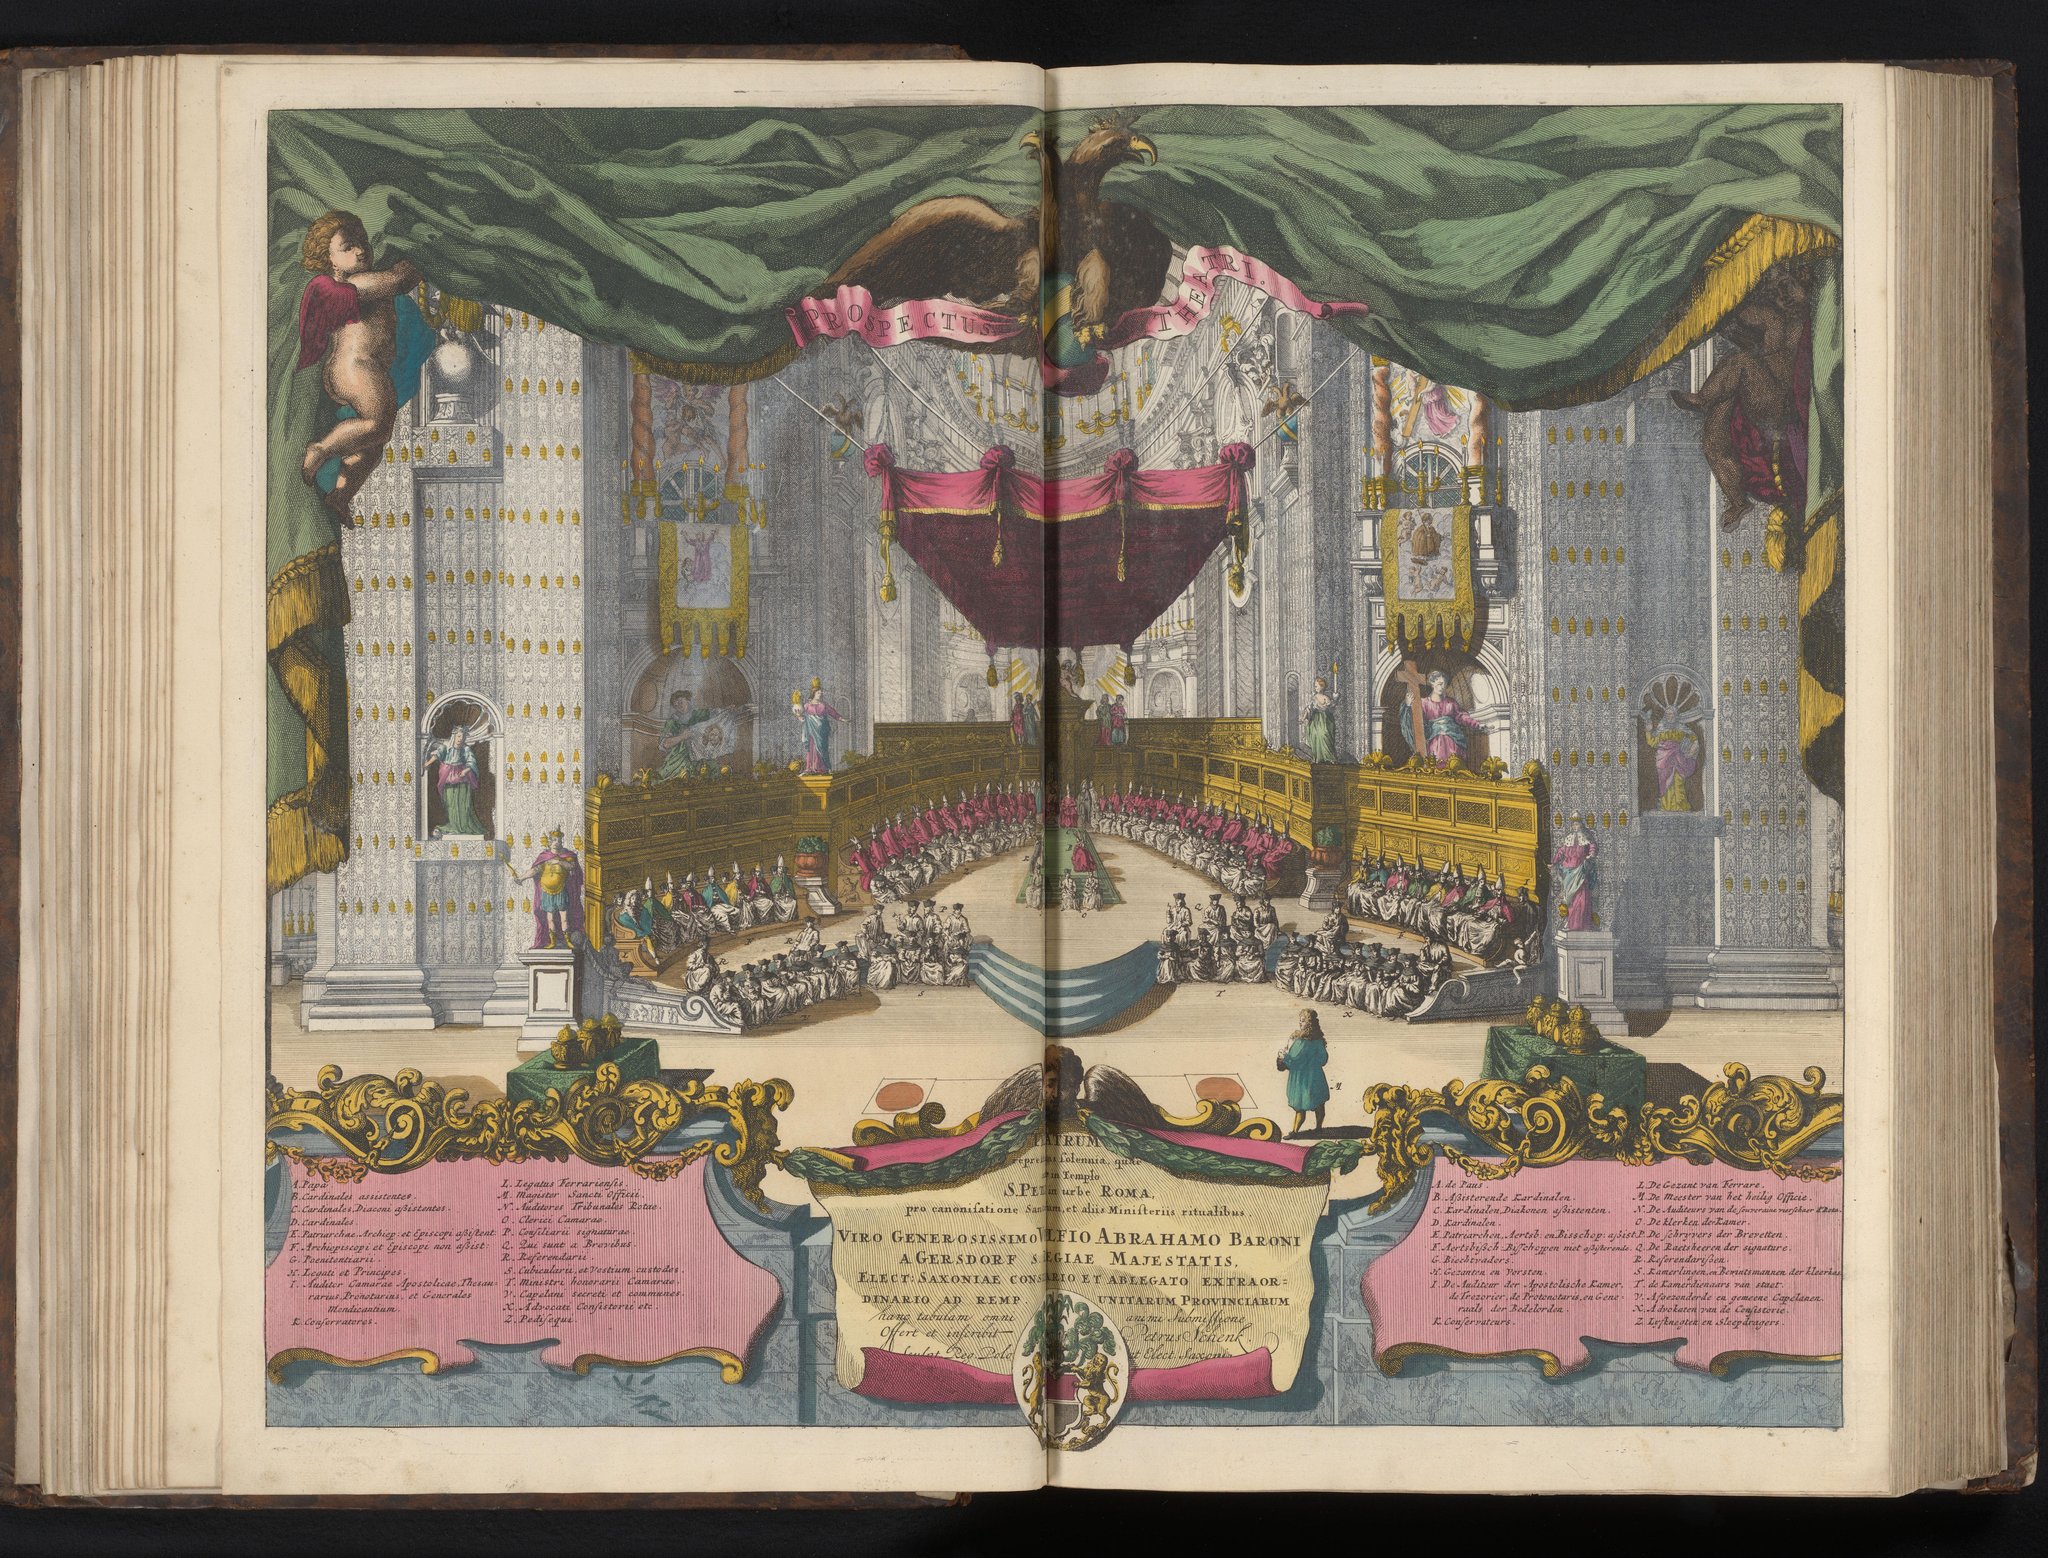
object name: album leaf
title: Gezicht in de Sint-Pietersbasiliek tijdens een heiligverklaring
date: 1675-1711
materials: paper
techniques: colour, etching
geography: the hague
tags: cardinal, interior of church, pope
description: Gezicht in het koor van de Sint-Pietersbasiliek tijdens een heiligverklaringsceremonie. Linksonder een verklarende lijst met letters in het Italiaans. Rechtsonder een verklarende lijst met letters in het Nederlands. Prent maakt deel uit van een album.